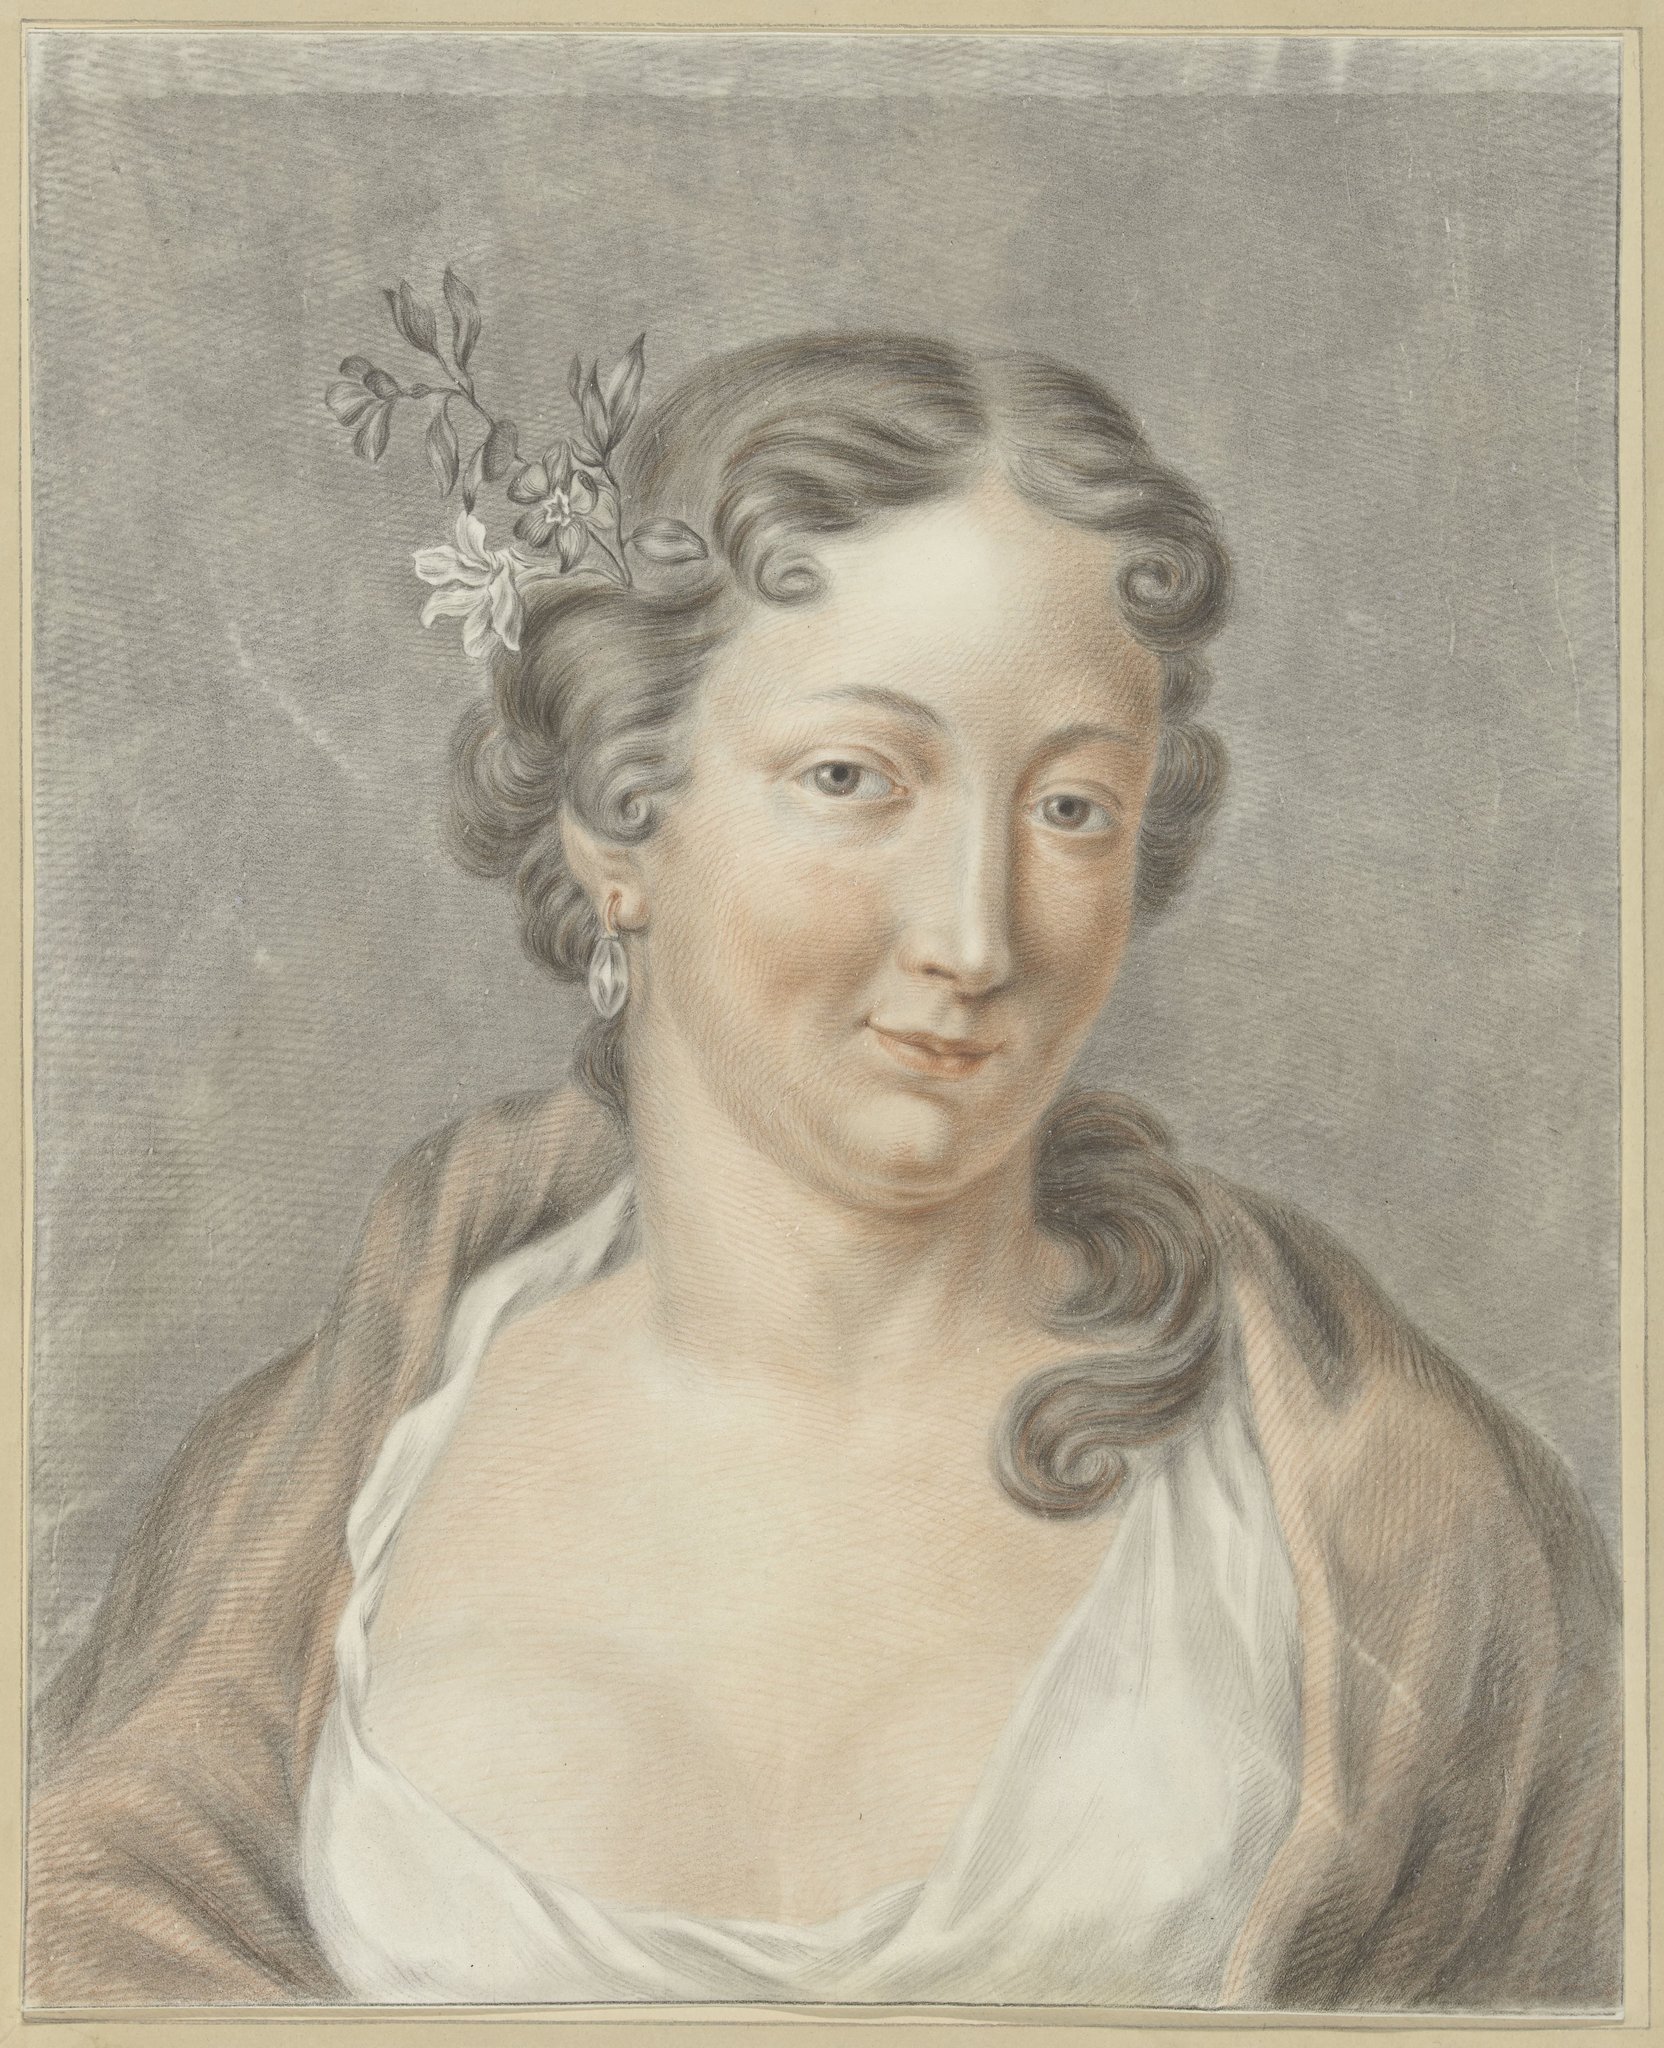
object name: drawing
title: Jonge vrouw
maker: abraham delfos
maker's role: draughtsman, painter, print maker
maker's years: 1731-1820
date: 1741-1820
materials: chalk, parchment